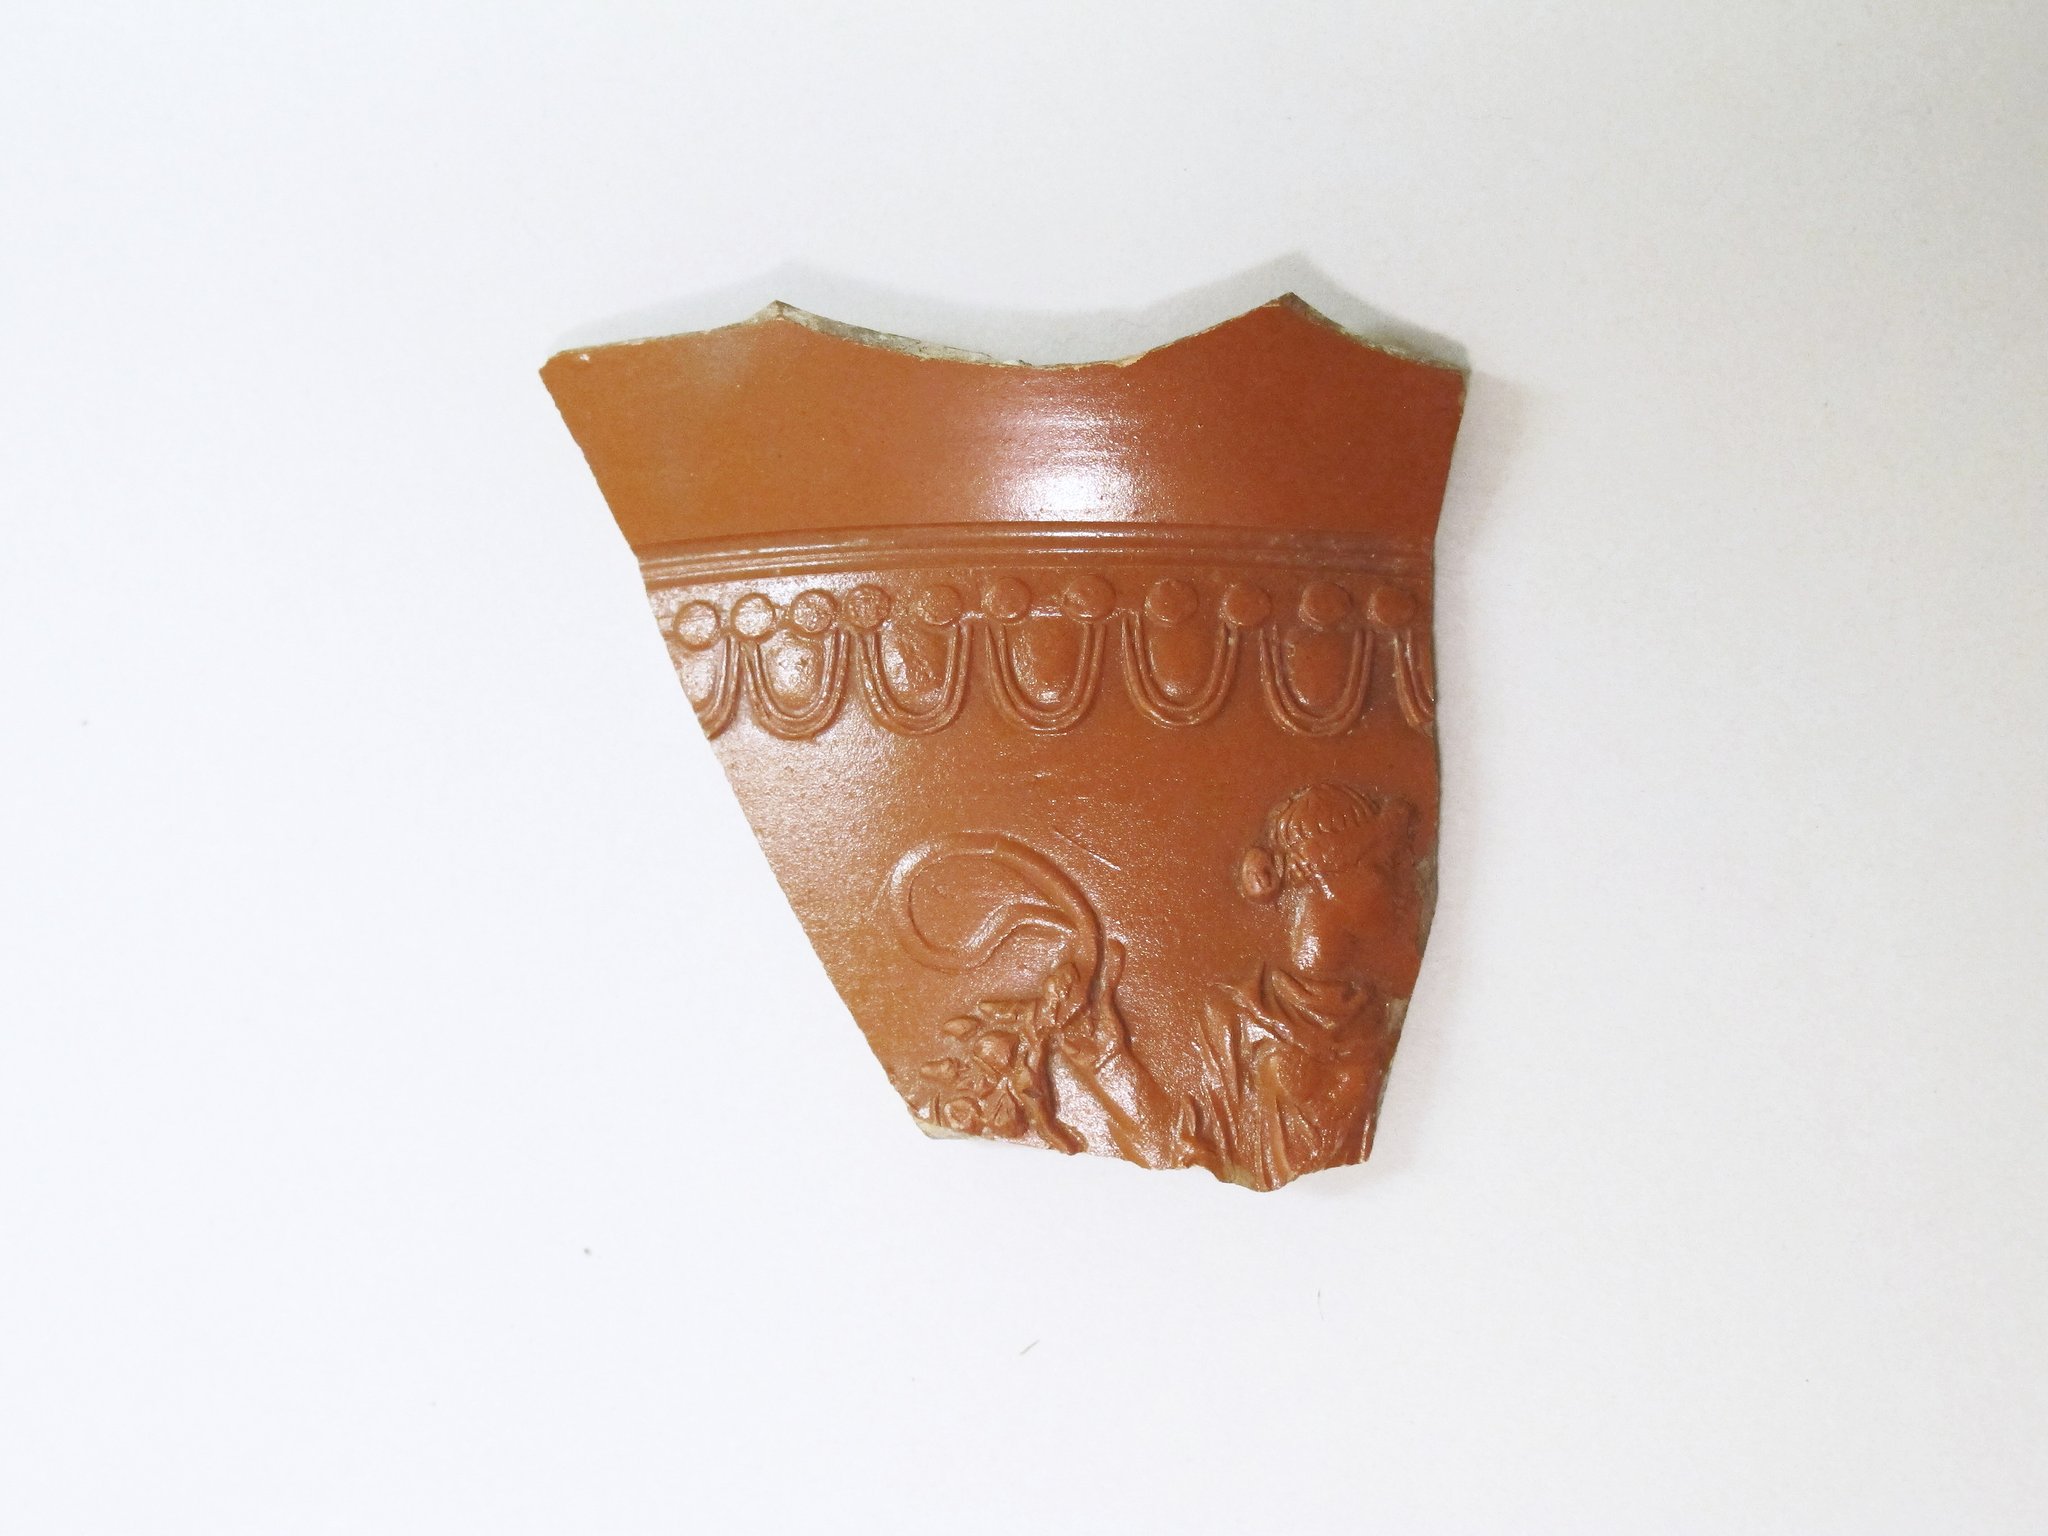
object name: vase fragment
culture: roman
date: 100 BCE-100 CE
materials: terracotta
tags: garlands,women